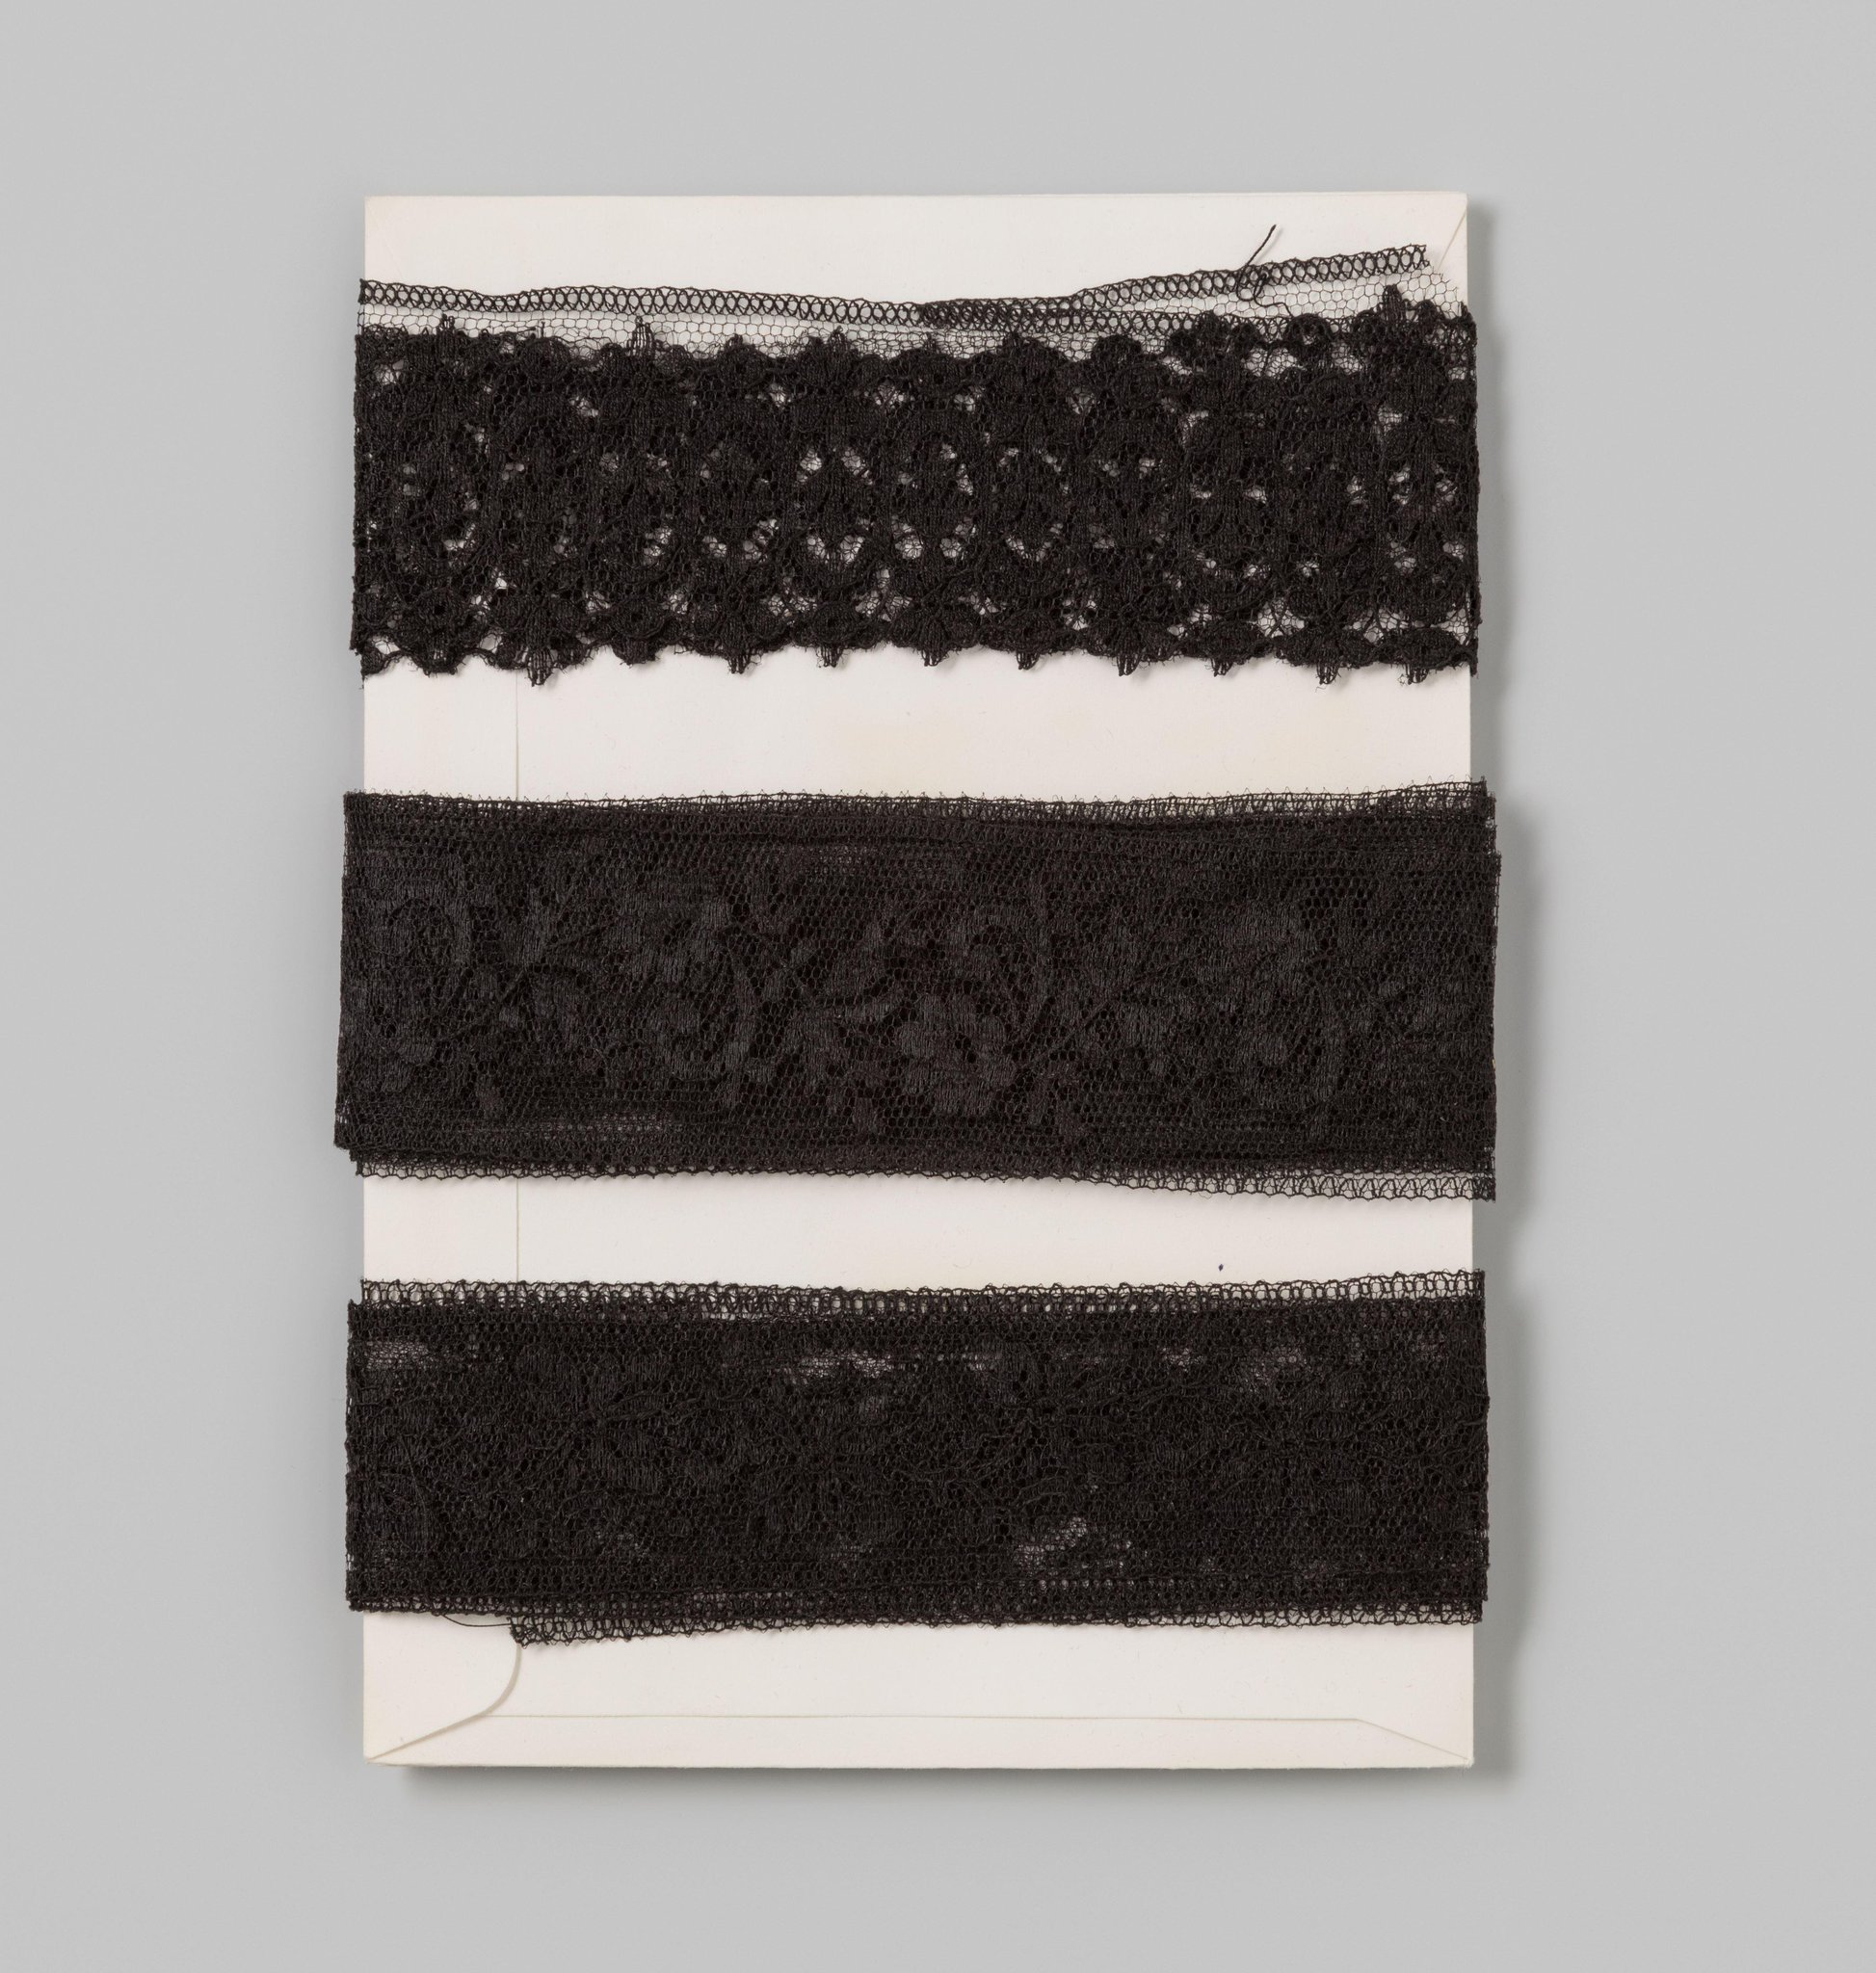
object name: ribbon material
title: Tussenzetsel van zwarte tuledoorstop met bloem- en bladmotief en c-vormige voluten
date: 1920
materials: fiber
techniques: stopwork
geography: france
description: Tussenzetsel van zwarte tuledoorstop met bloem- en bladmotief en c-vormige voluten.